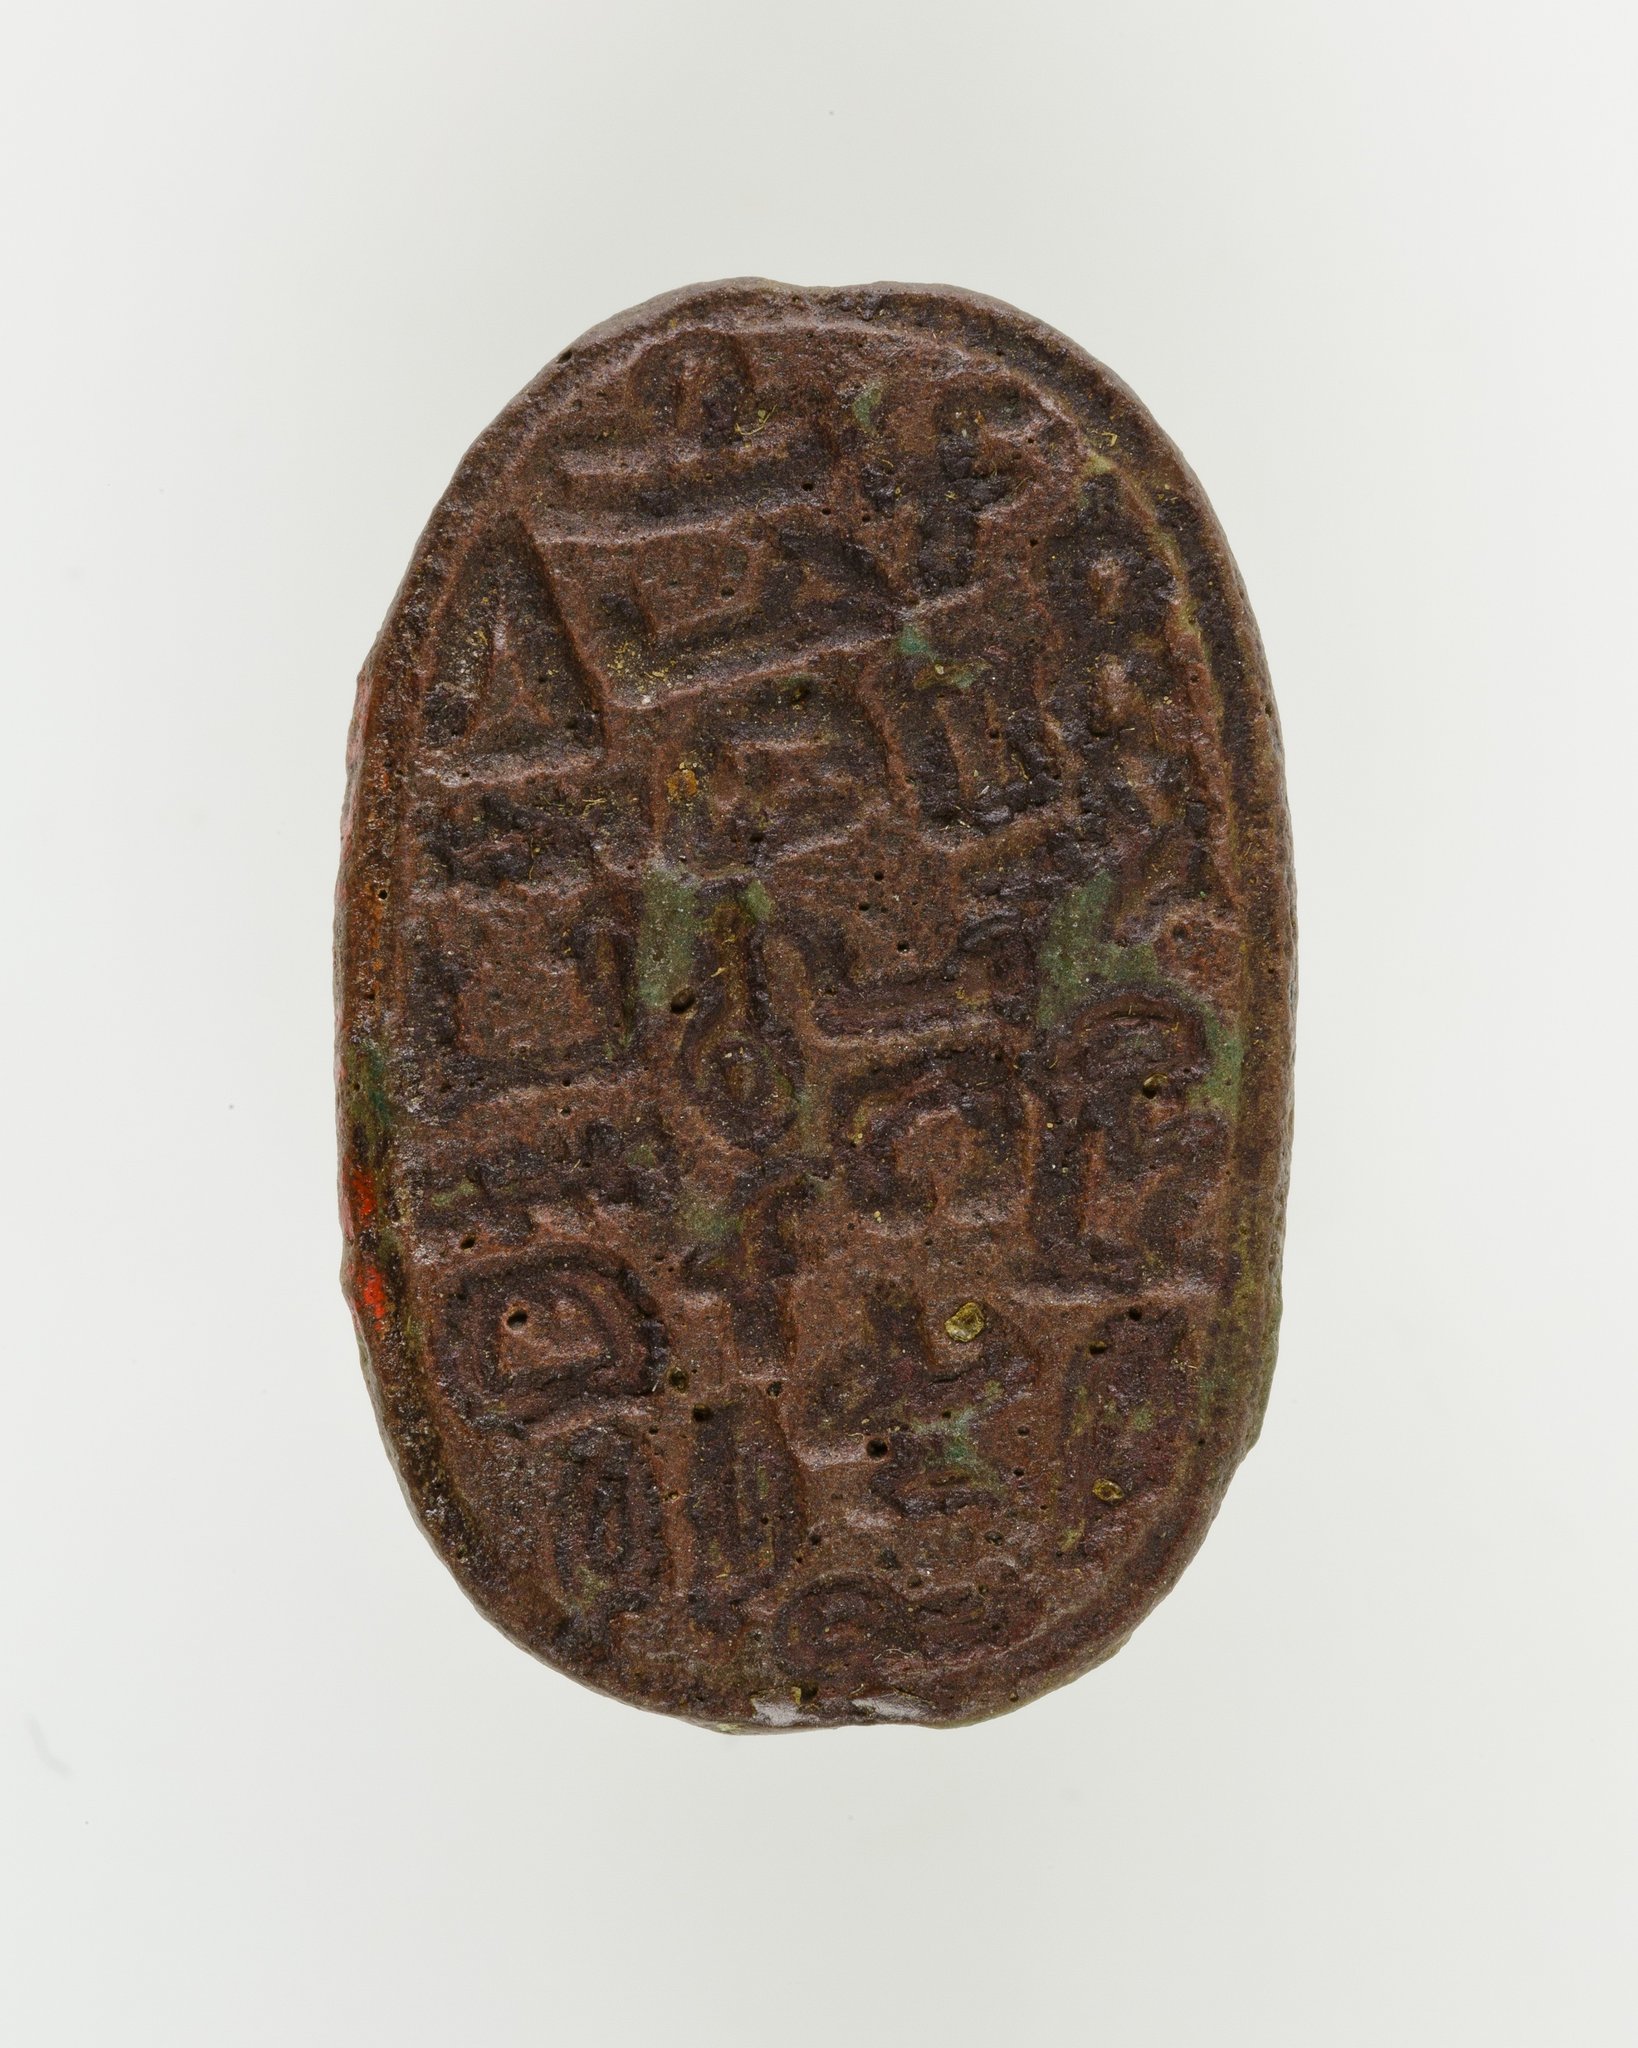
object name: scarab, official, private name and title, epithet, ptah, iy, offering formula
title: Scarab of an Official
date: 1850-1640 BCE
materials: faience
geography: egypt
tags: scarabs